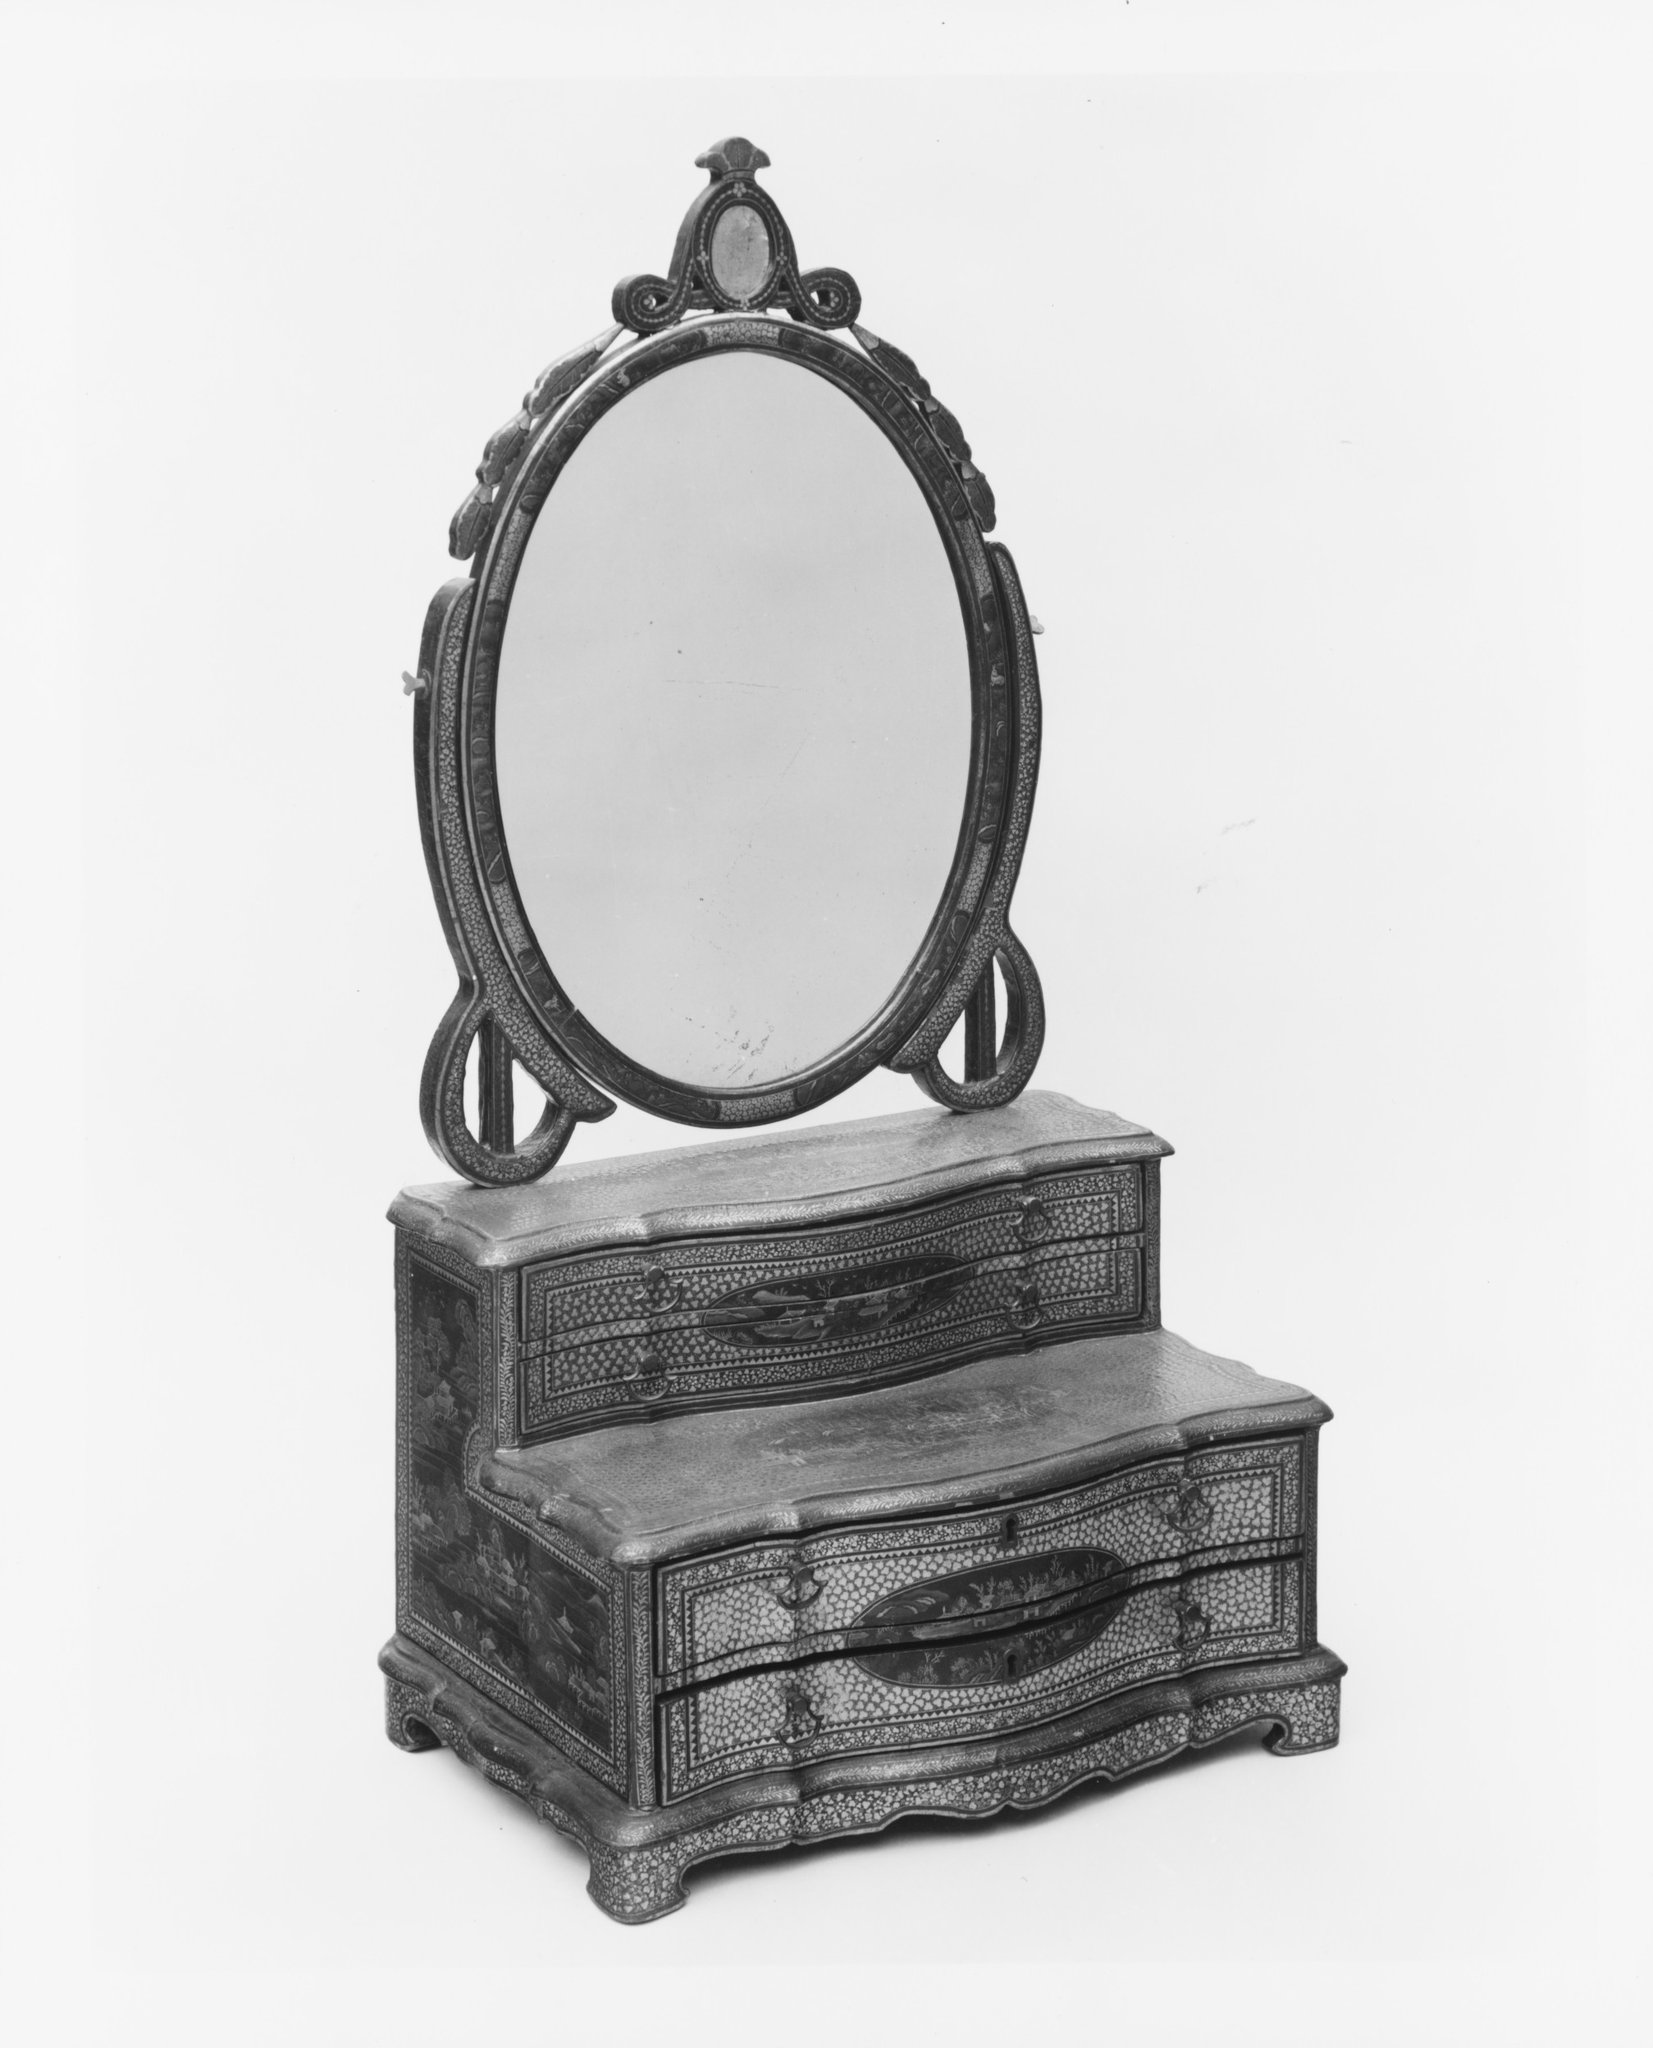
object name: dressing glass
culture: chinese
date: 1790-1800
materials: wood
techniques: lacquer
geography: china